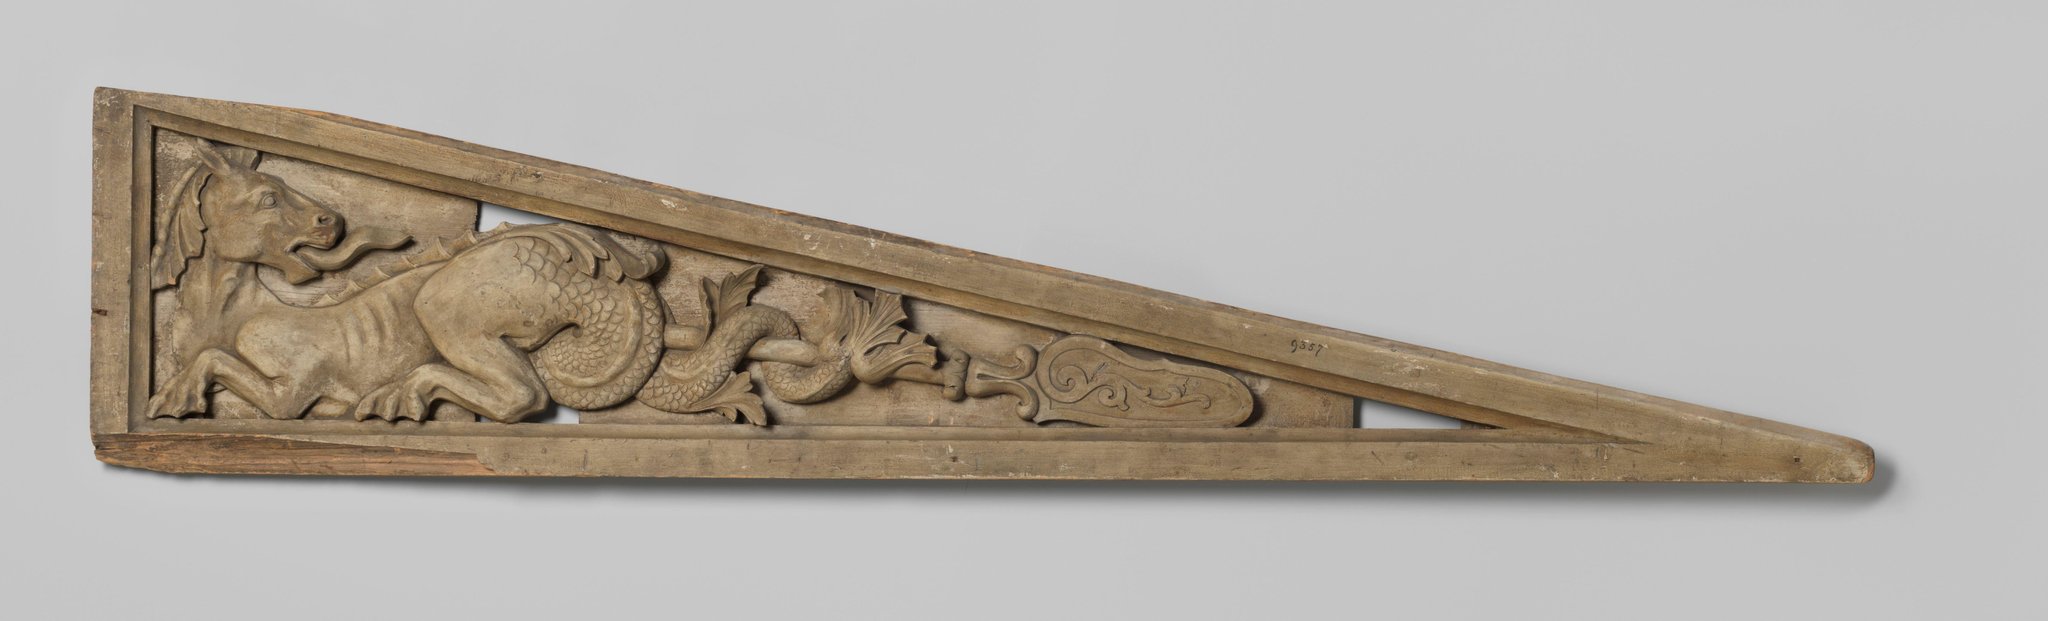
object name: sculpture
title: Frontispiece in vorm zeemonster met paardenkop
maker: Anonymous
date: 1700-1800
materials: wood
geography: northern netherlands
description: Vulling van een half frontespies, gesneden uit lindehout, voorstellende een zeemonster, met een paardekop en lichaam, dat zijn staart om een roer slingert.